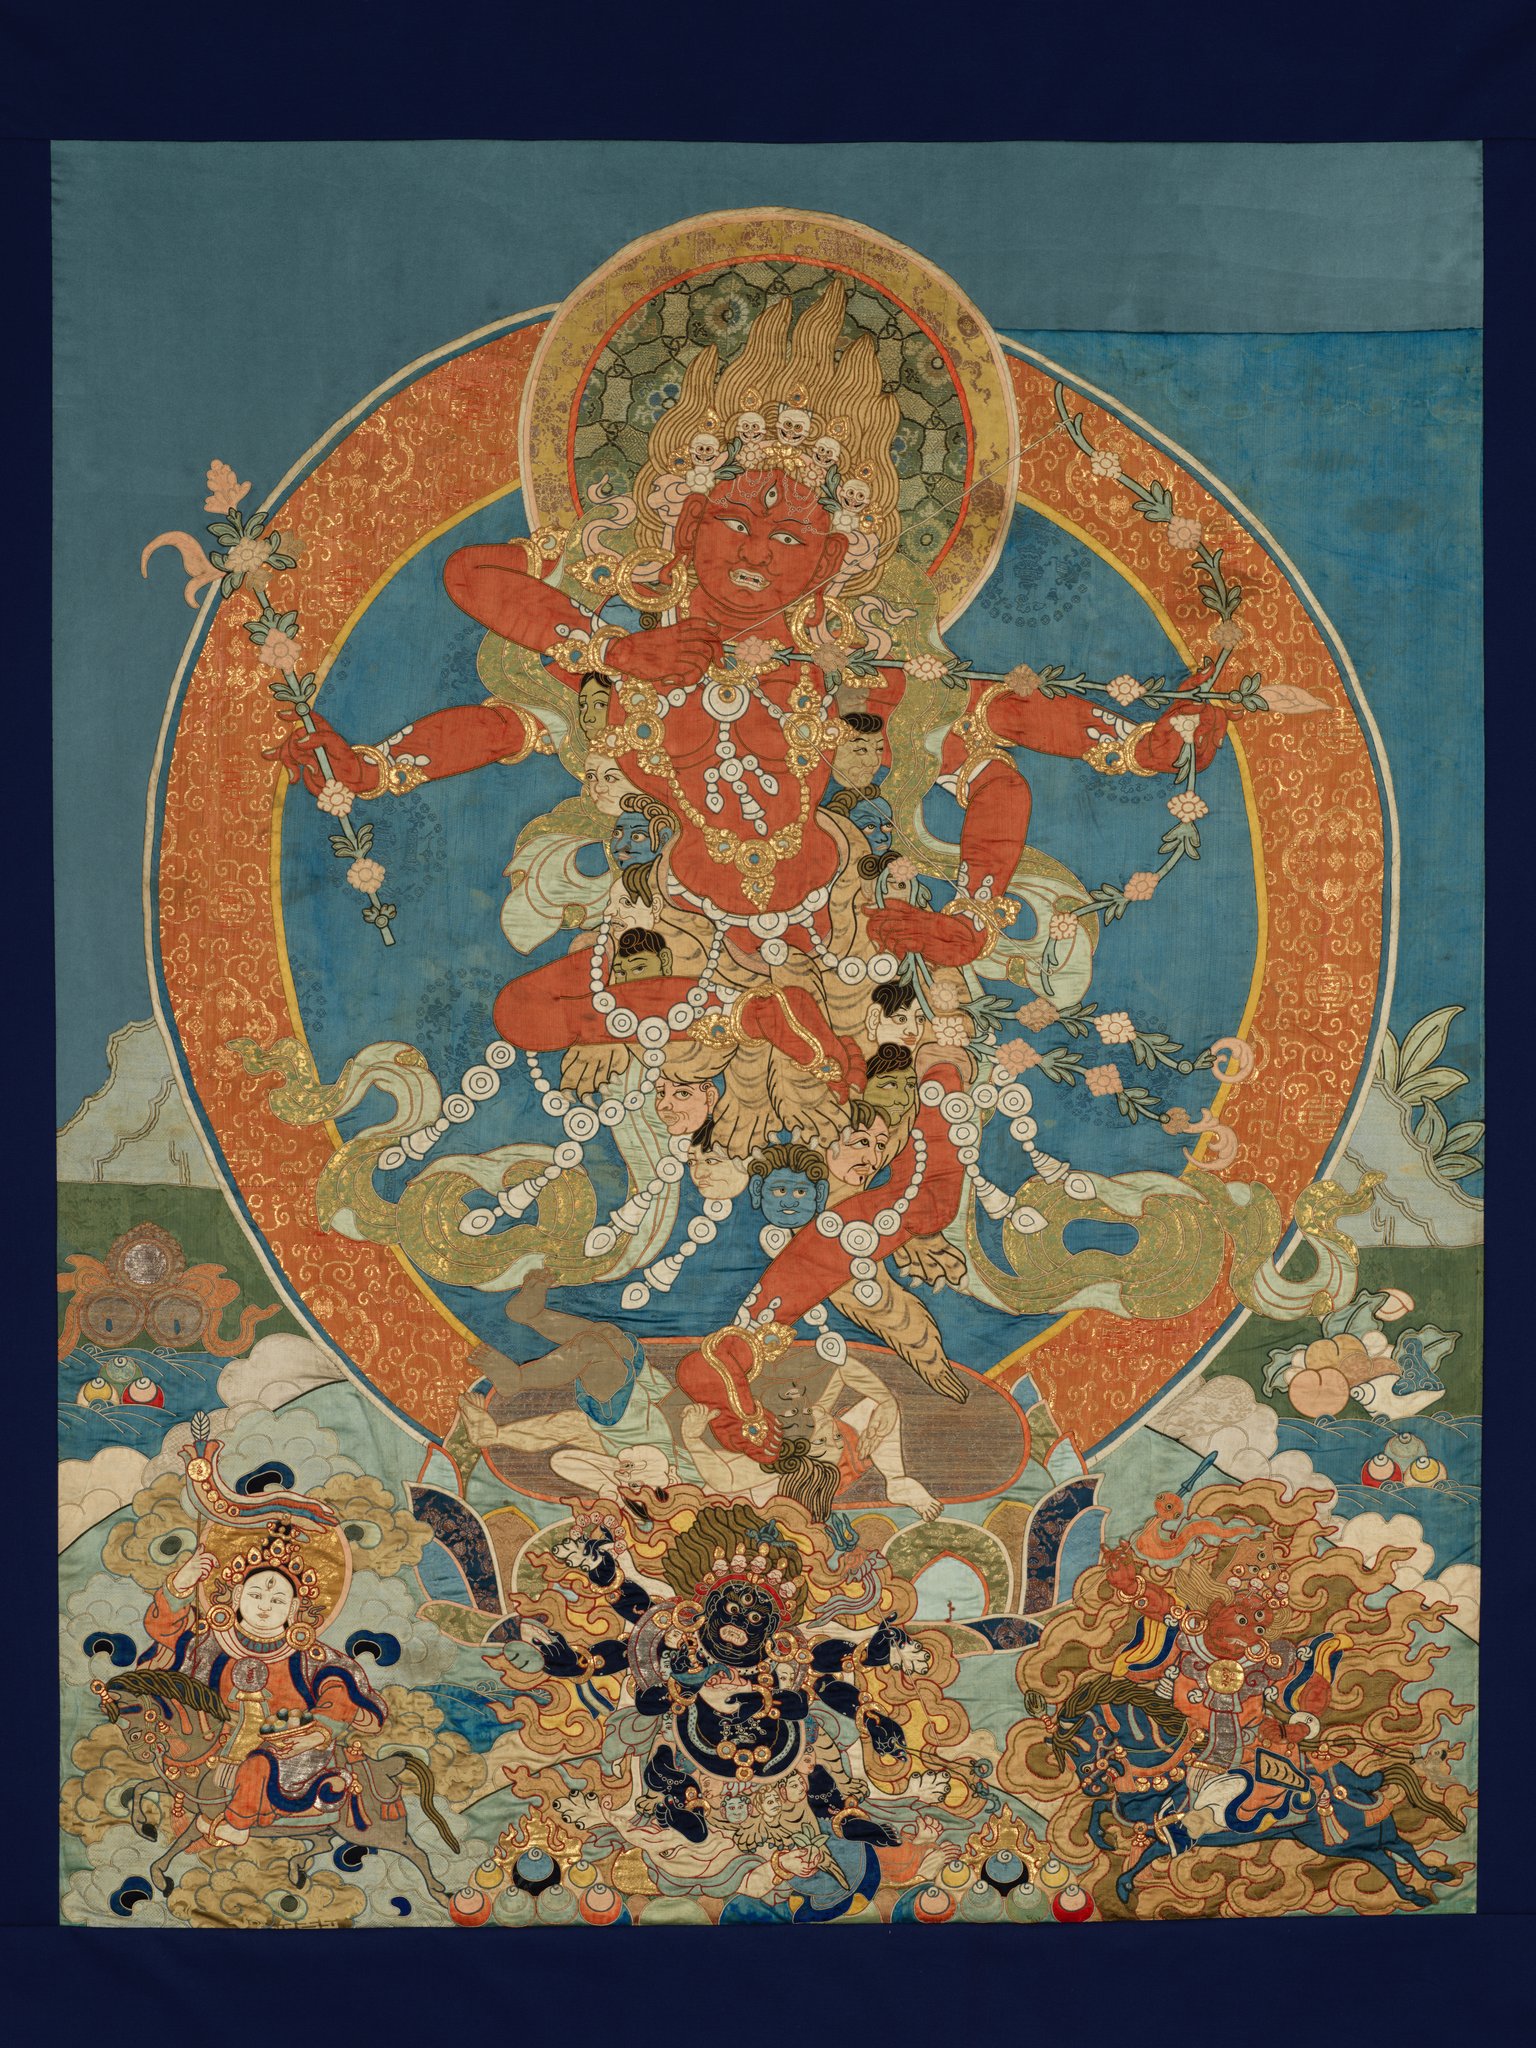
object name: thangka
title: Kurukulla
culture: tibetan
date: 1801-1900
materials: textile, silk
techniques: brocade, damask, embroidery, painting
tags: goddess